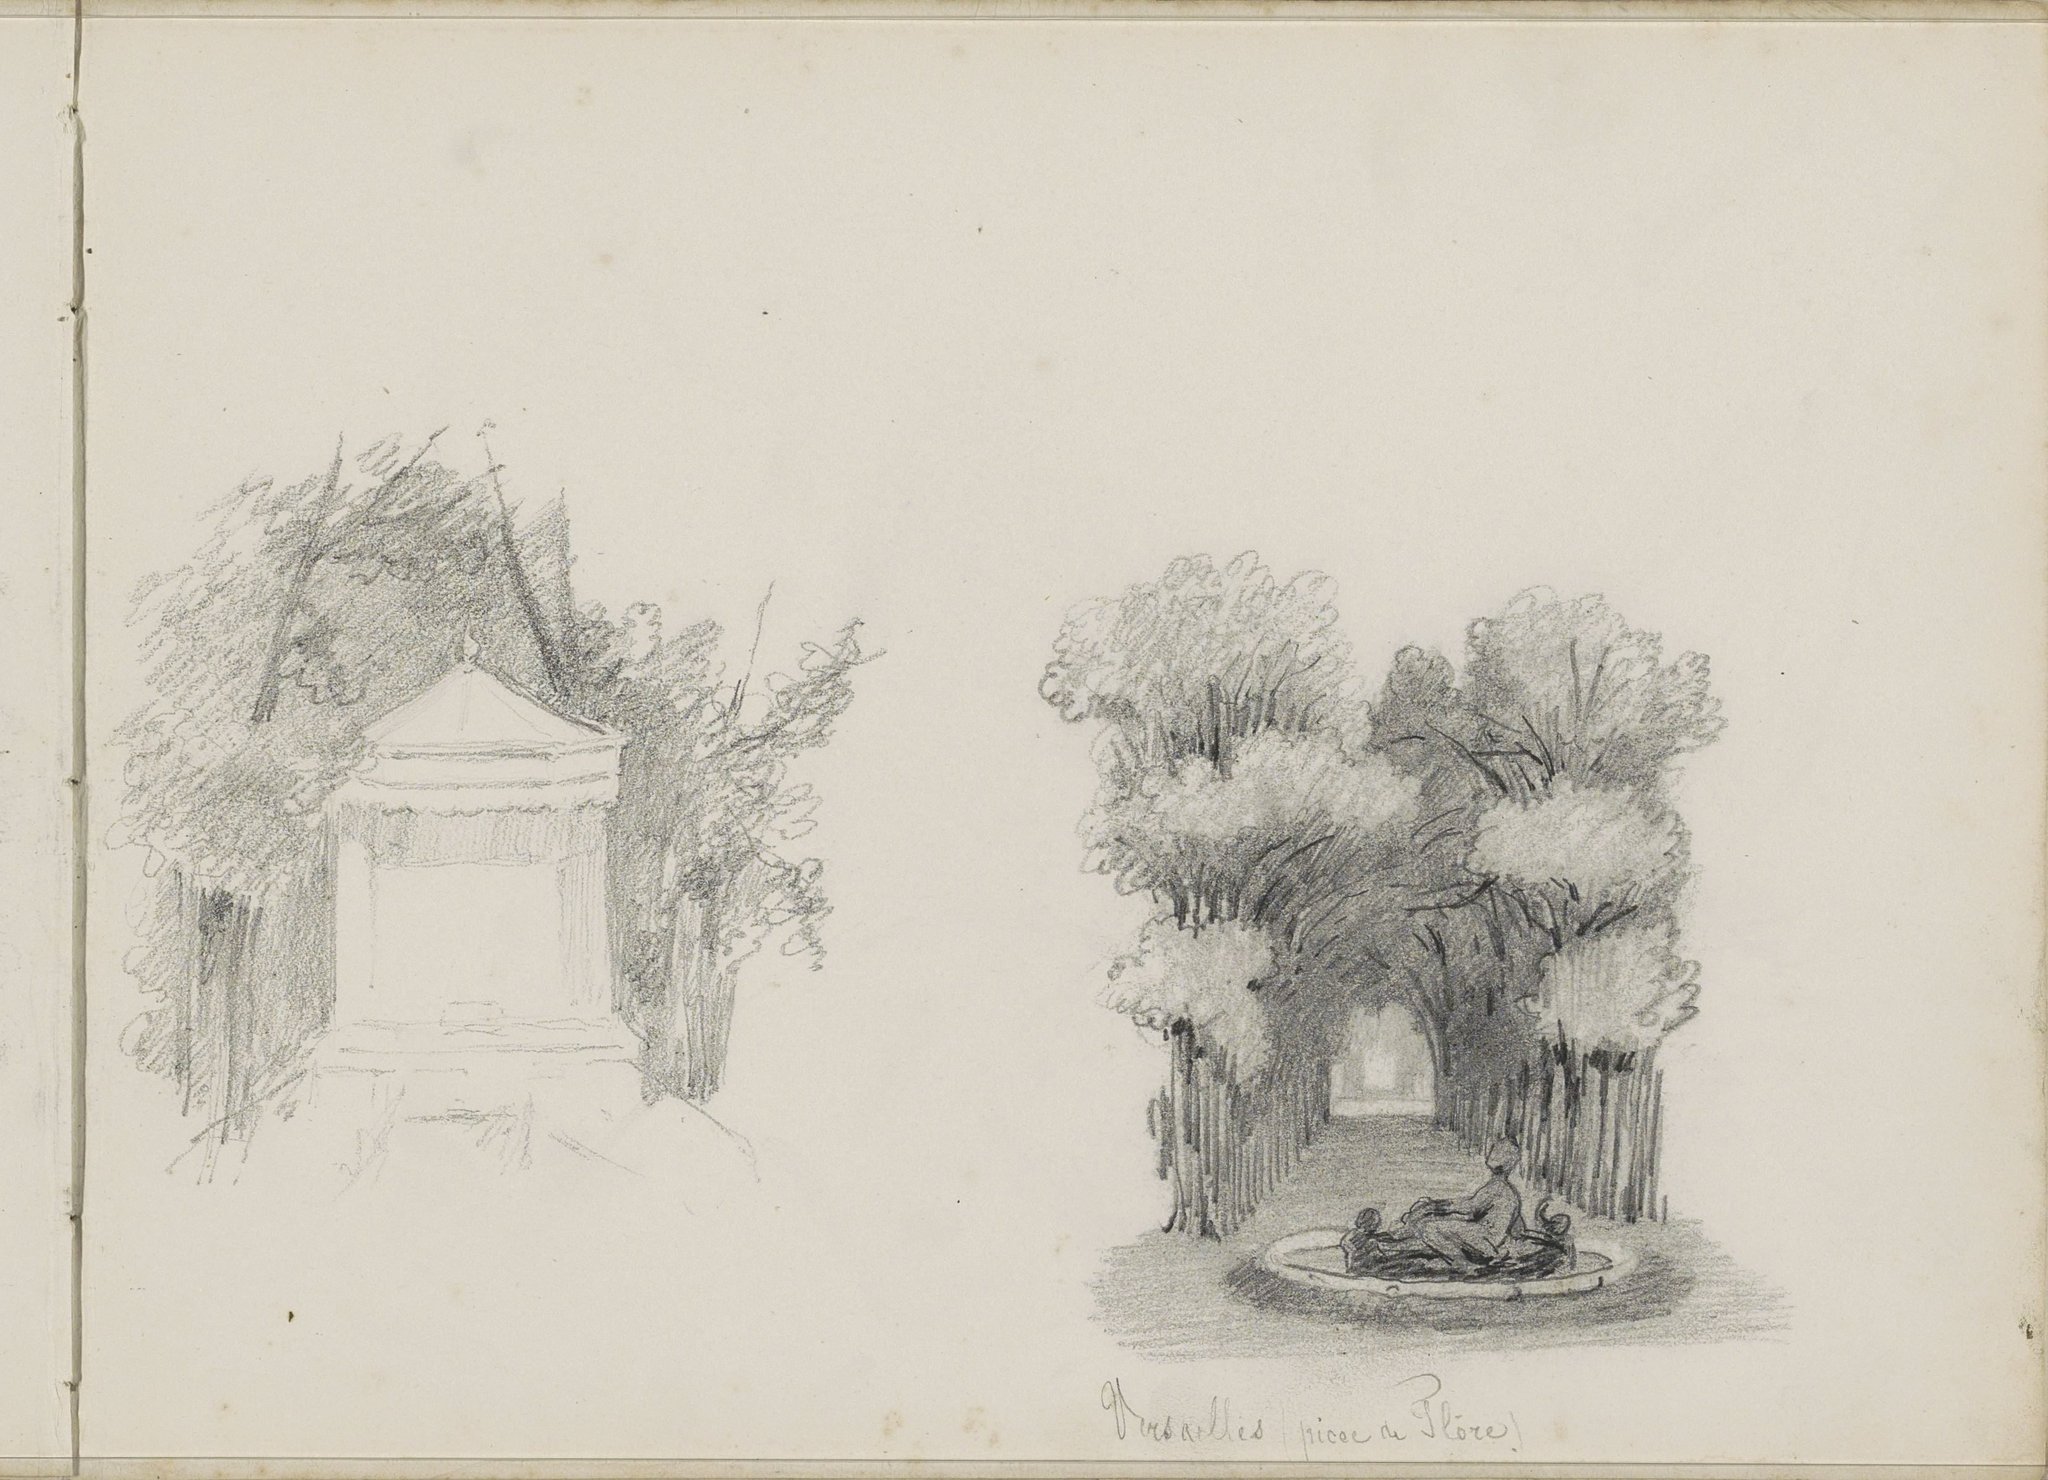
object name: sketchbook leaf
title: Bassin de Flore te Versailles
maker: gerrit postma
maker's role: draughtsman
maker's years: 1819-1894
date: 1858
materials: paper, pencil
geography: versailles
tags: french or architectonic garden; formal garden, garden pond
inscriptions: annotation: ‘Versailles (piece de Flore)’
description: Blad 6 recto uit een schetsboek met 52 bladen.